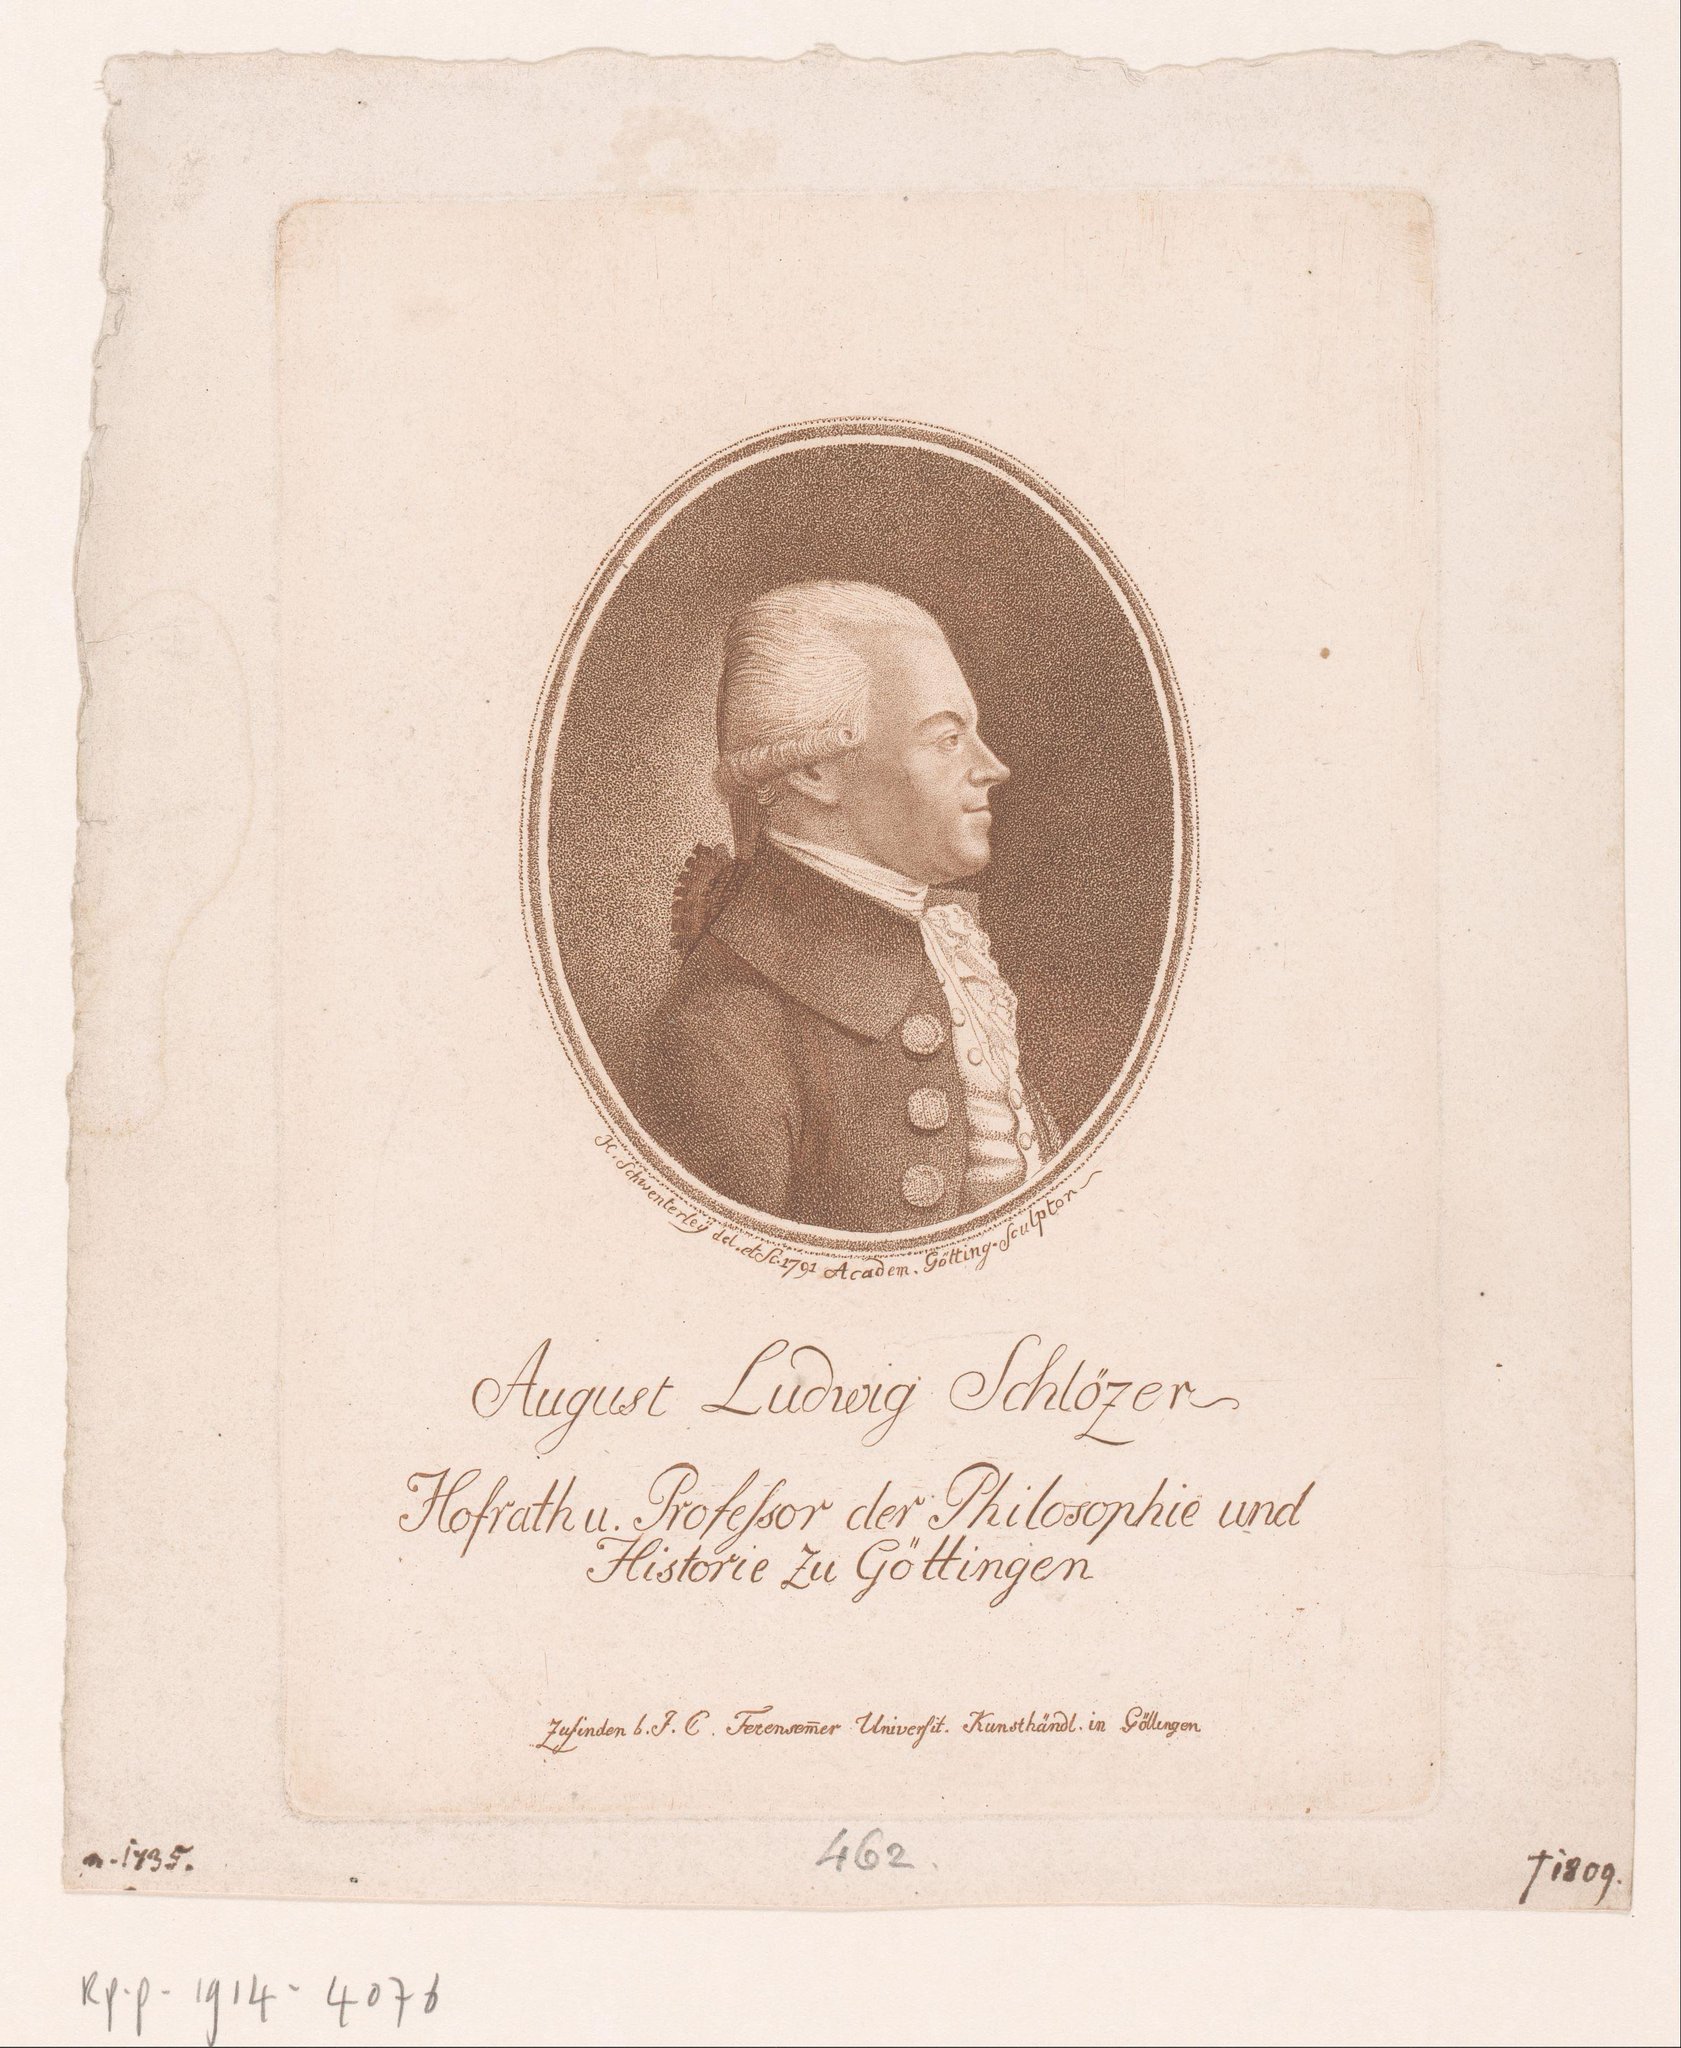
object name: print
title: Portret van August Ludwig von Schlözer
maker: heinrich schwenterley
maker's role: print maker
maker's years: 1749-1815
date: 1791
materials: paper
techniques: stippling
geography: gottingen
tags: historical persons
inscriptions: collector's mark: Lugt 2228